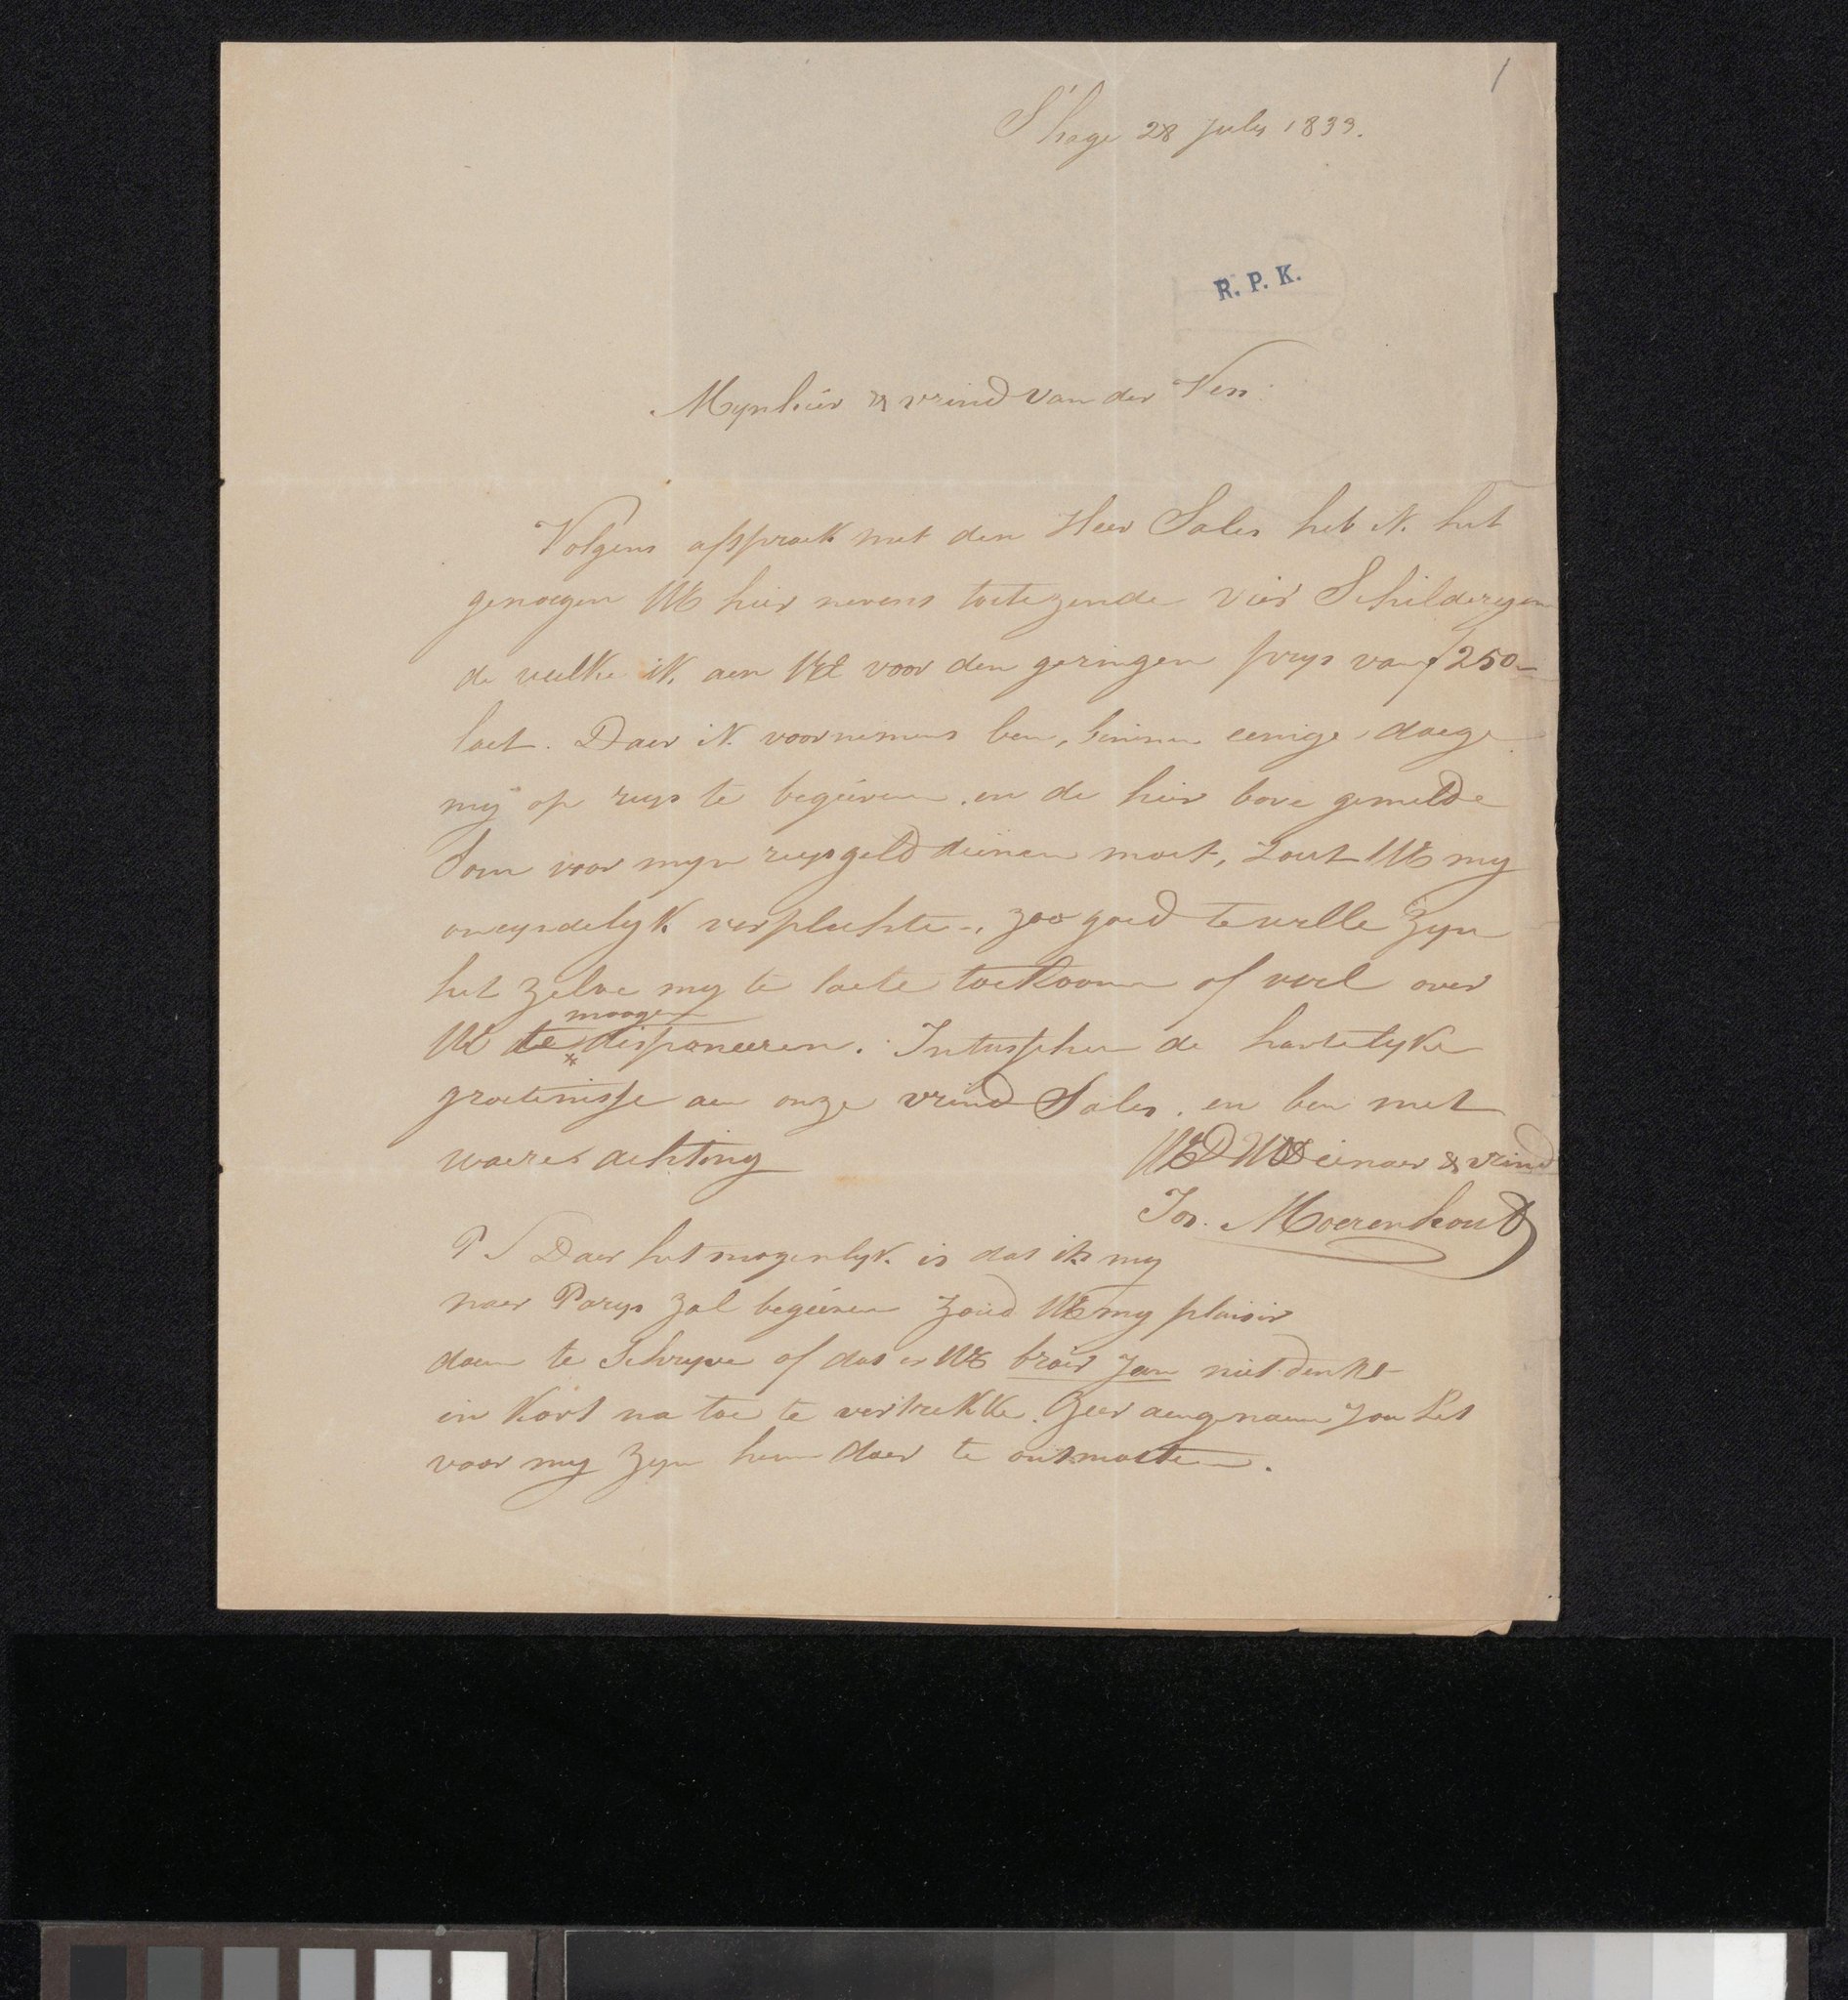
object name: letter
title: Brief aan onbekend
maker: joseph moerenhout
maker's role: draughtsman, painter, print maker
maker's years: 1801-1874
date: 1833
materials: ink, paper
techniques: pen, writing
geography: the hague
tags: art trade, art shop, painting (including book-illumination, miniature-painting), money, paris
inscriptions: collector's mark: Lugt 2233